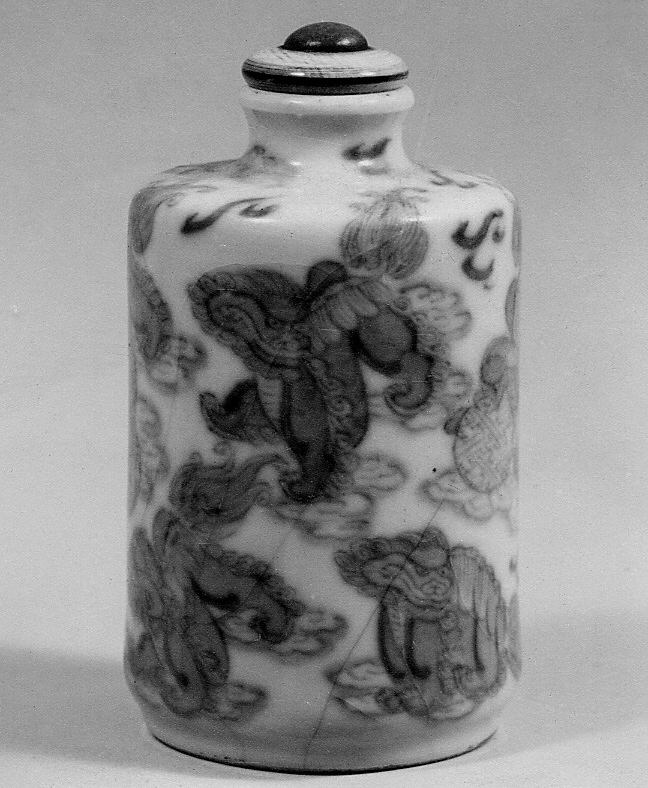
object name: snuff bottle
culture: chinese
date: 1723-1735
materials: coral, ivory, porcelain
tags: lions